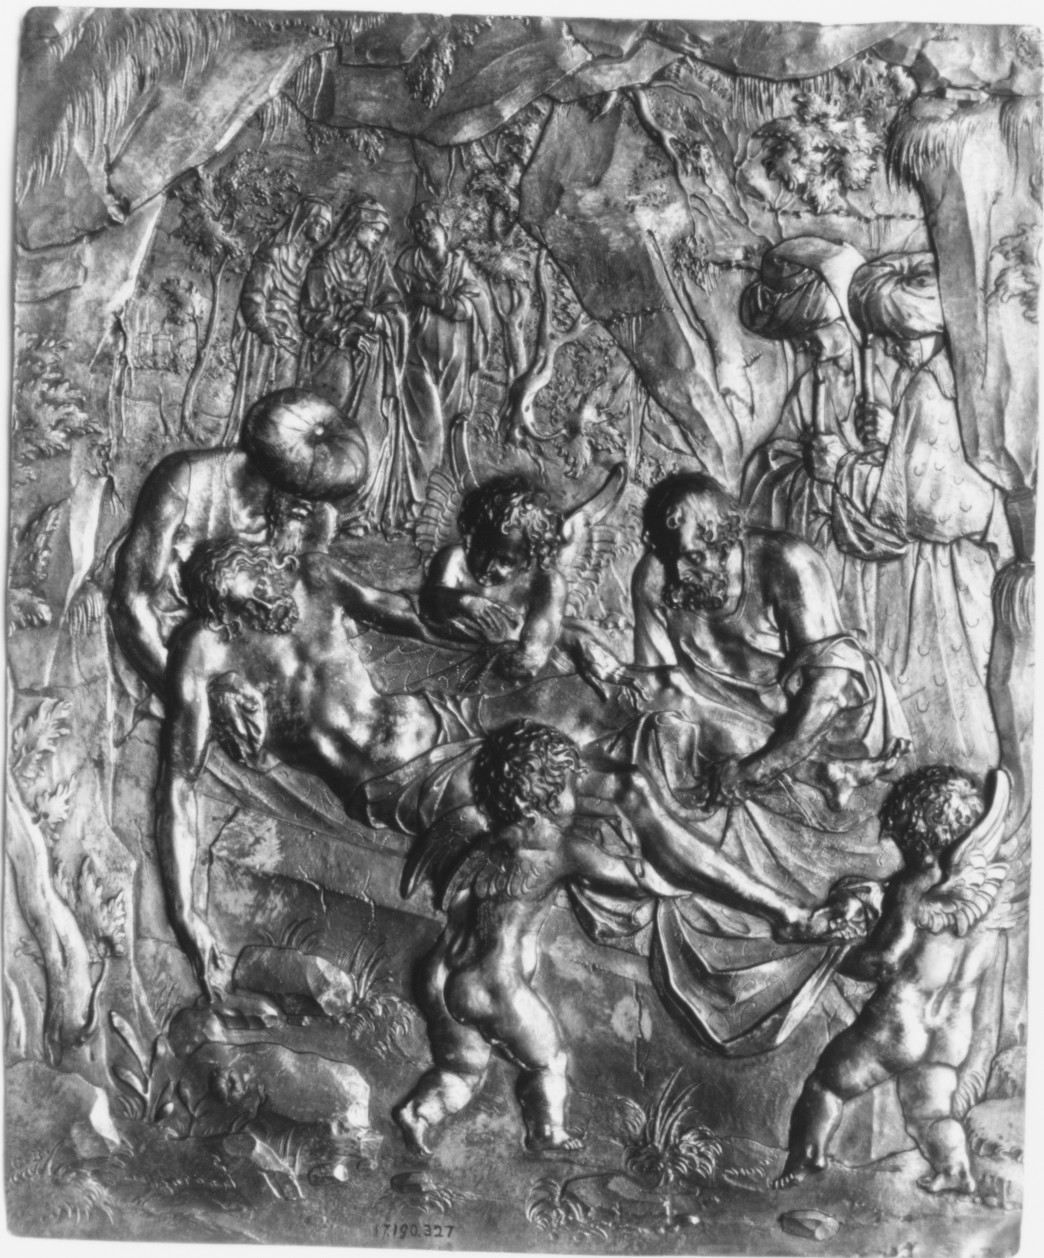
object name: plaquette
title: Entombment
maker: monogrammist cb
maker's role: maker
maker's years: 1550-1700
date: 1567-1633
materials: silver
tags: men,women,putti,christ,entombment